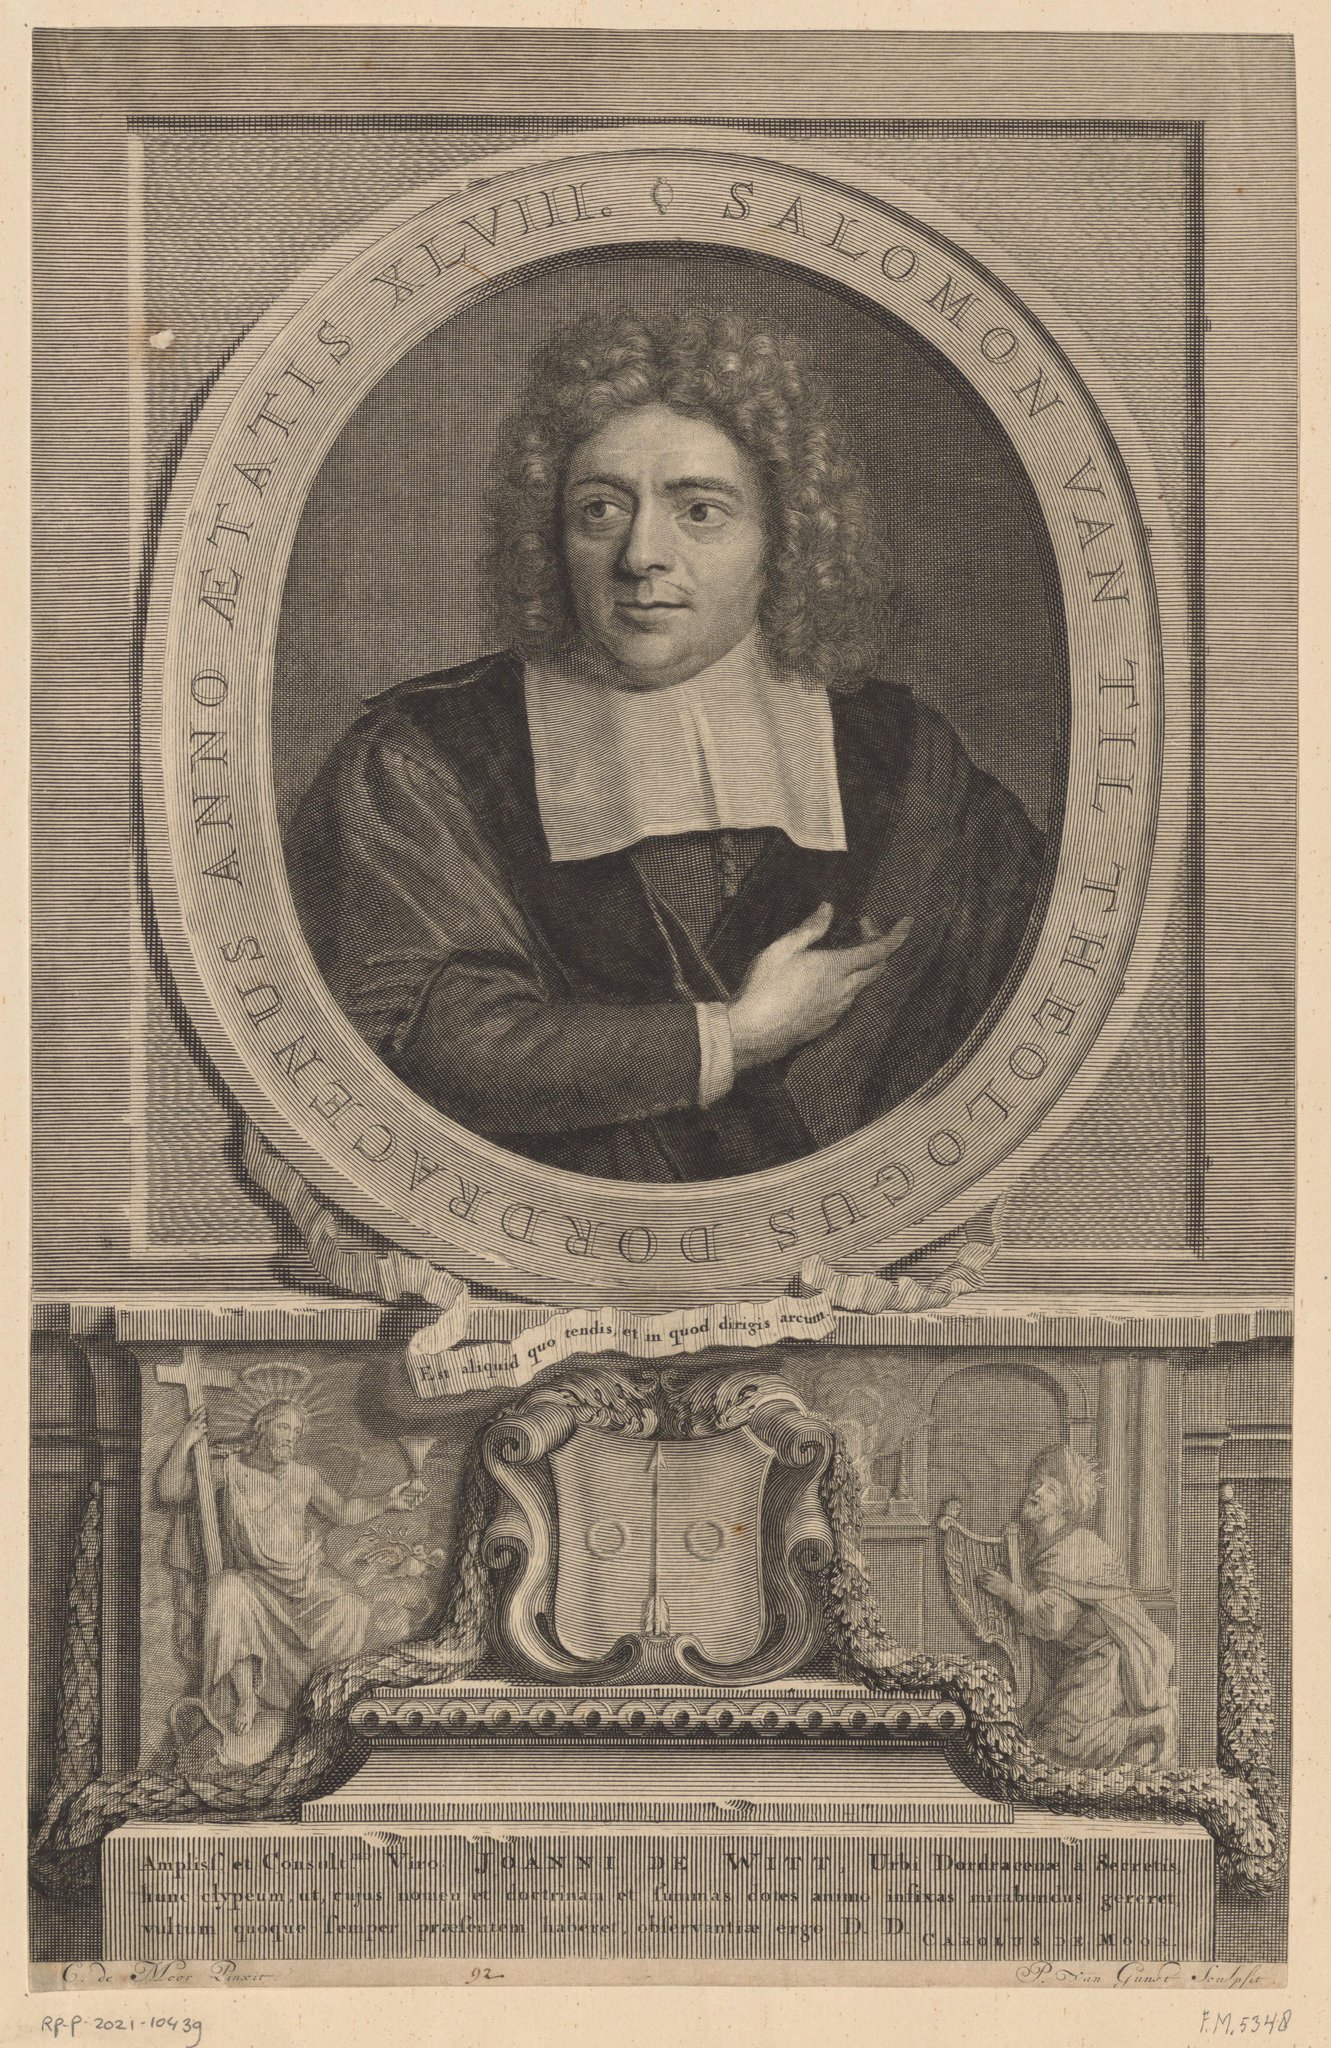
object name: print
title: Portret van Salomon van Til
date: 1703-1732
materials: paper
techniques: engraving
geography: amsterdam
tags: leiden, historical persons, armorial bearing, heraldry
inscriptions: inscription: ‘92’, collector's mark: Lugt 240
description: Salomon van Til, Coccejaans predikant. De prent heeft een Latijns onderschrift. Onder de prent zijn wapenschild.